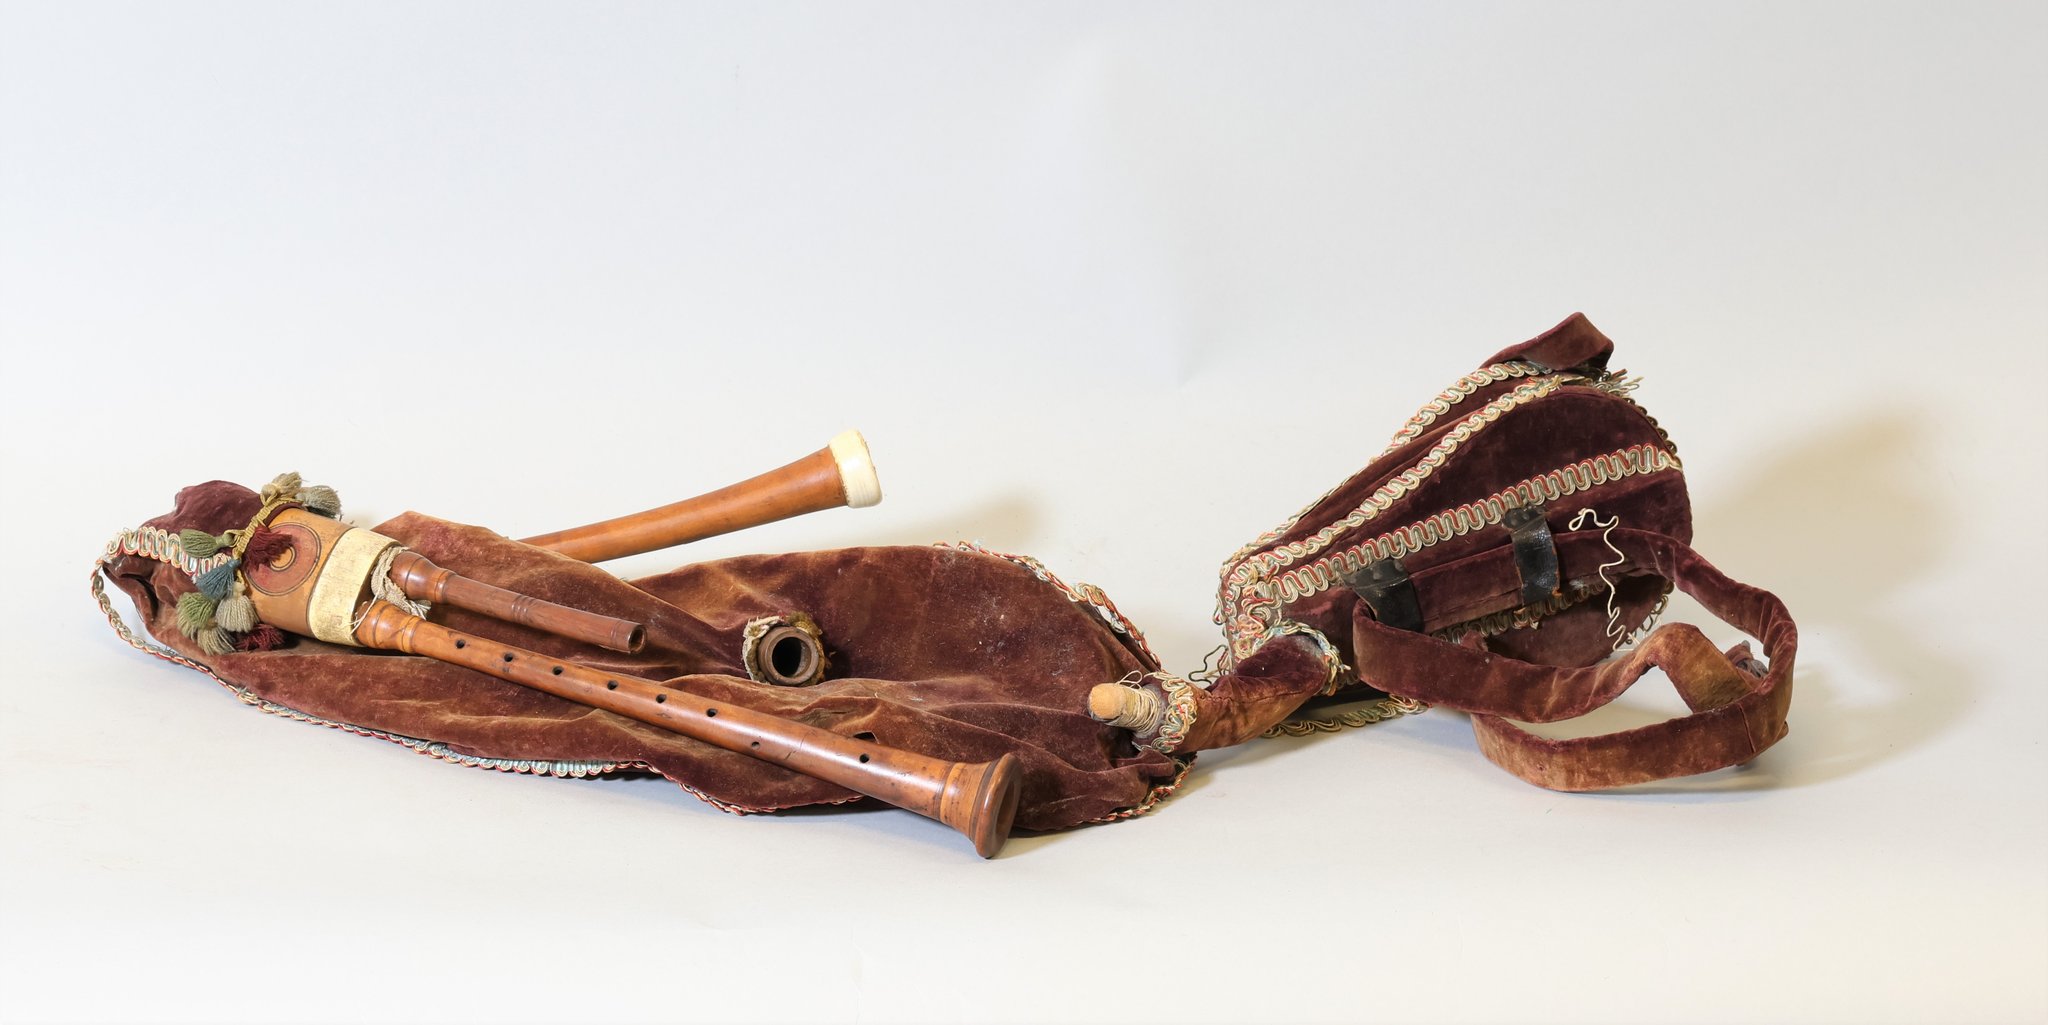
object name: cornemuse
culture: french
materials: bone, ivory, velvet, wood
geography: france